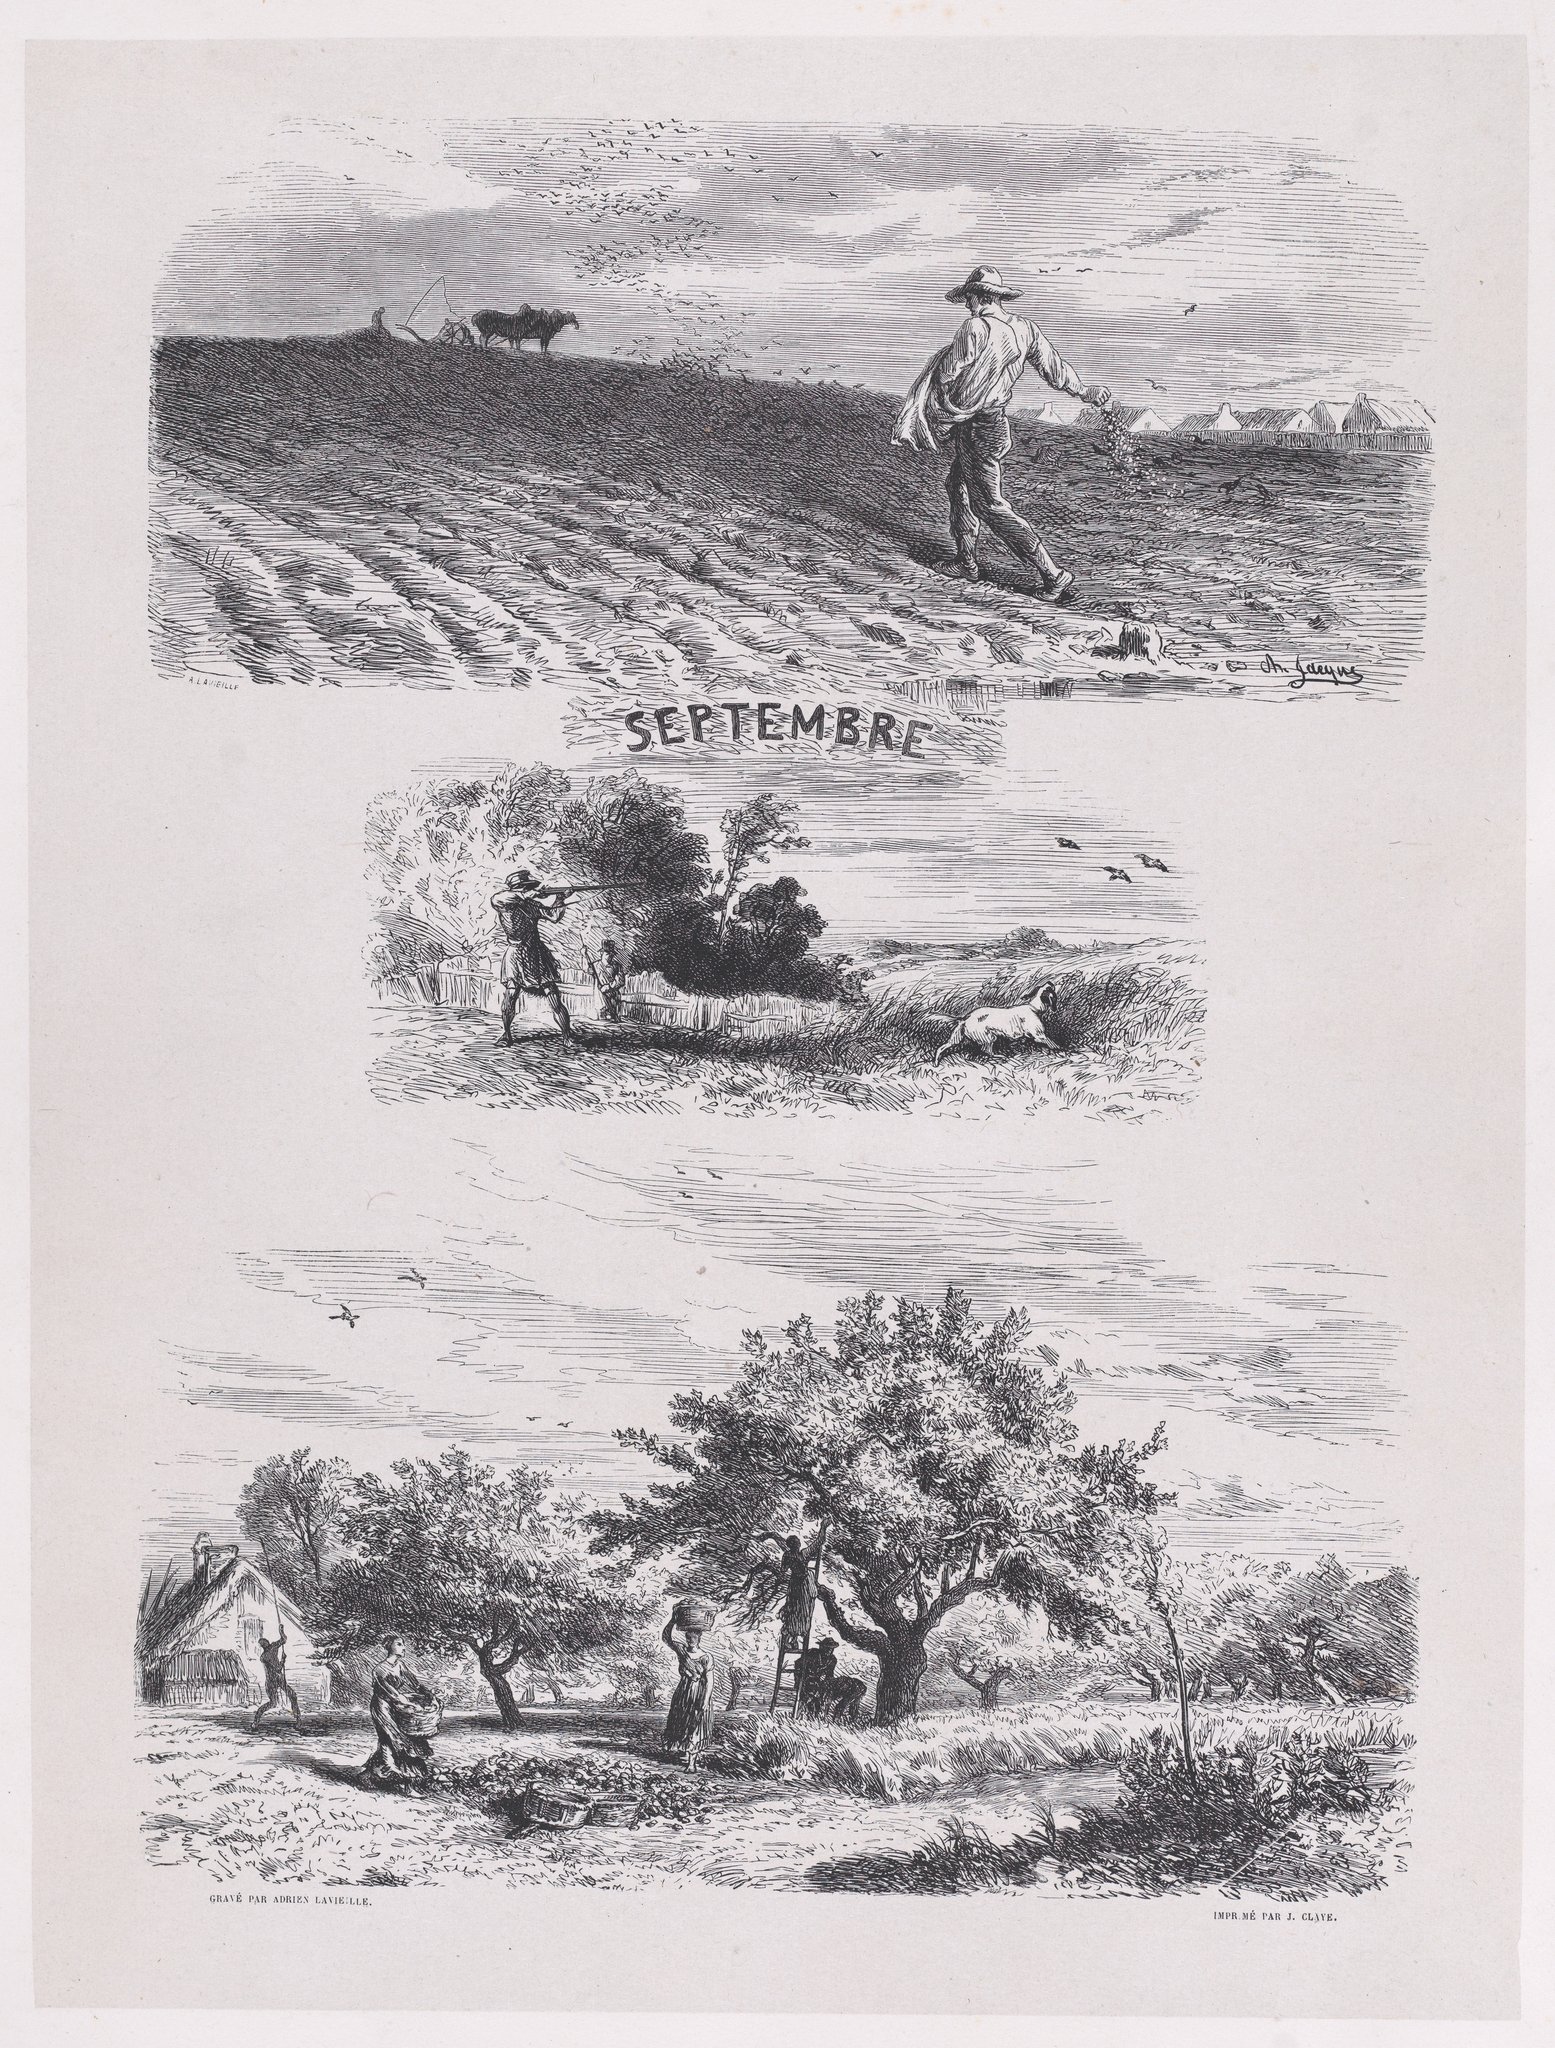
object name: print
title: September, from "Album of Rustic Subjects"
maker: charles émile jacque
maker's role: artist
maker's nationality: french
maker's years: 1813-1894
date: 1859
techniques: engraving